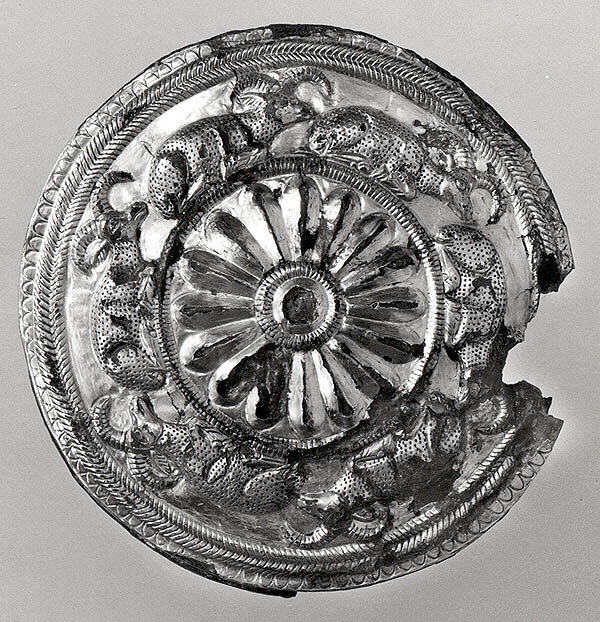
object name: roundel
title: Roundel with a rosette and recumbent horned animals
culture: elamite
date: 1400-1201 BCE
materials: bronze, foil, gold, silver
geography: iran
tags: animals,flowers